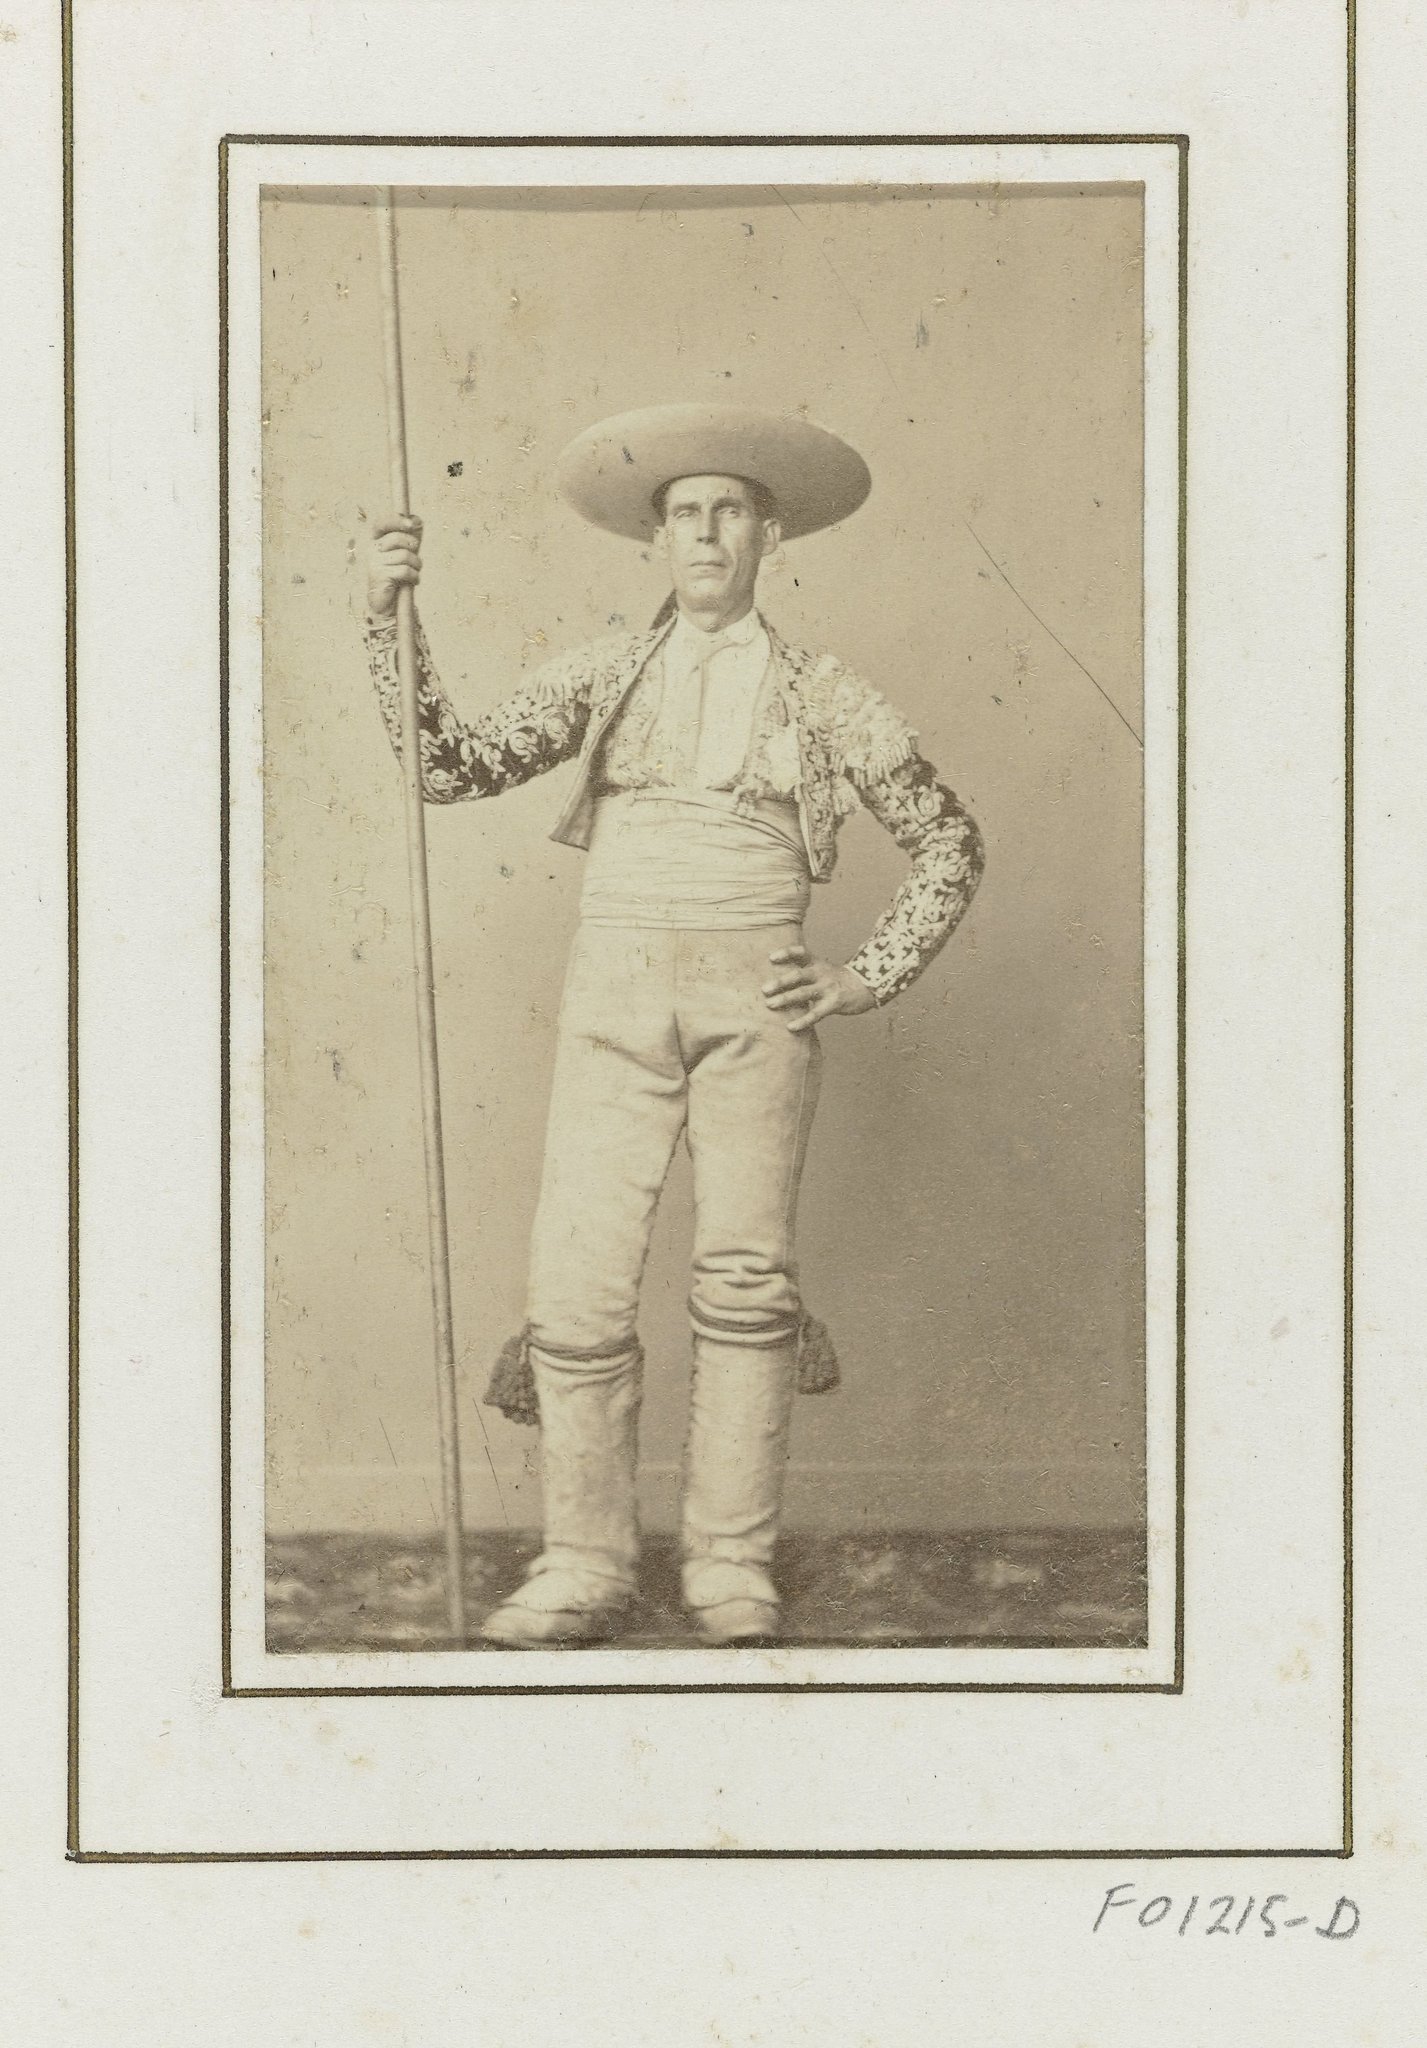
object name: photograph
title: Portret van een onbekende stierenvechter (picador), staand met lans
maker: juan laurent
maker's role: publisher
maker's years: 1816-1896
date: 1860-1875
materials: photographic support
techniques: albumen print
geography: spain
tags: adult man, bull-fighter, toreador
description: Onderdeel van Reisalbum met opnames van kunstwerken, personen en bezienswaardigheden in Spanje.